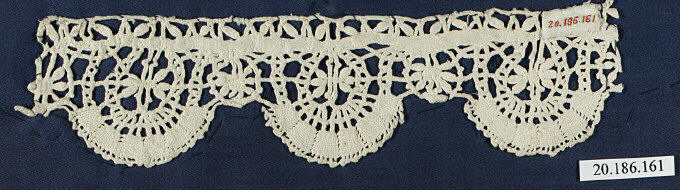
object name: edging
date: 1601-1700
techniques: lace